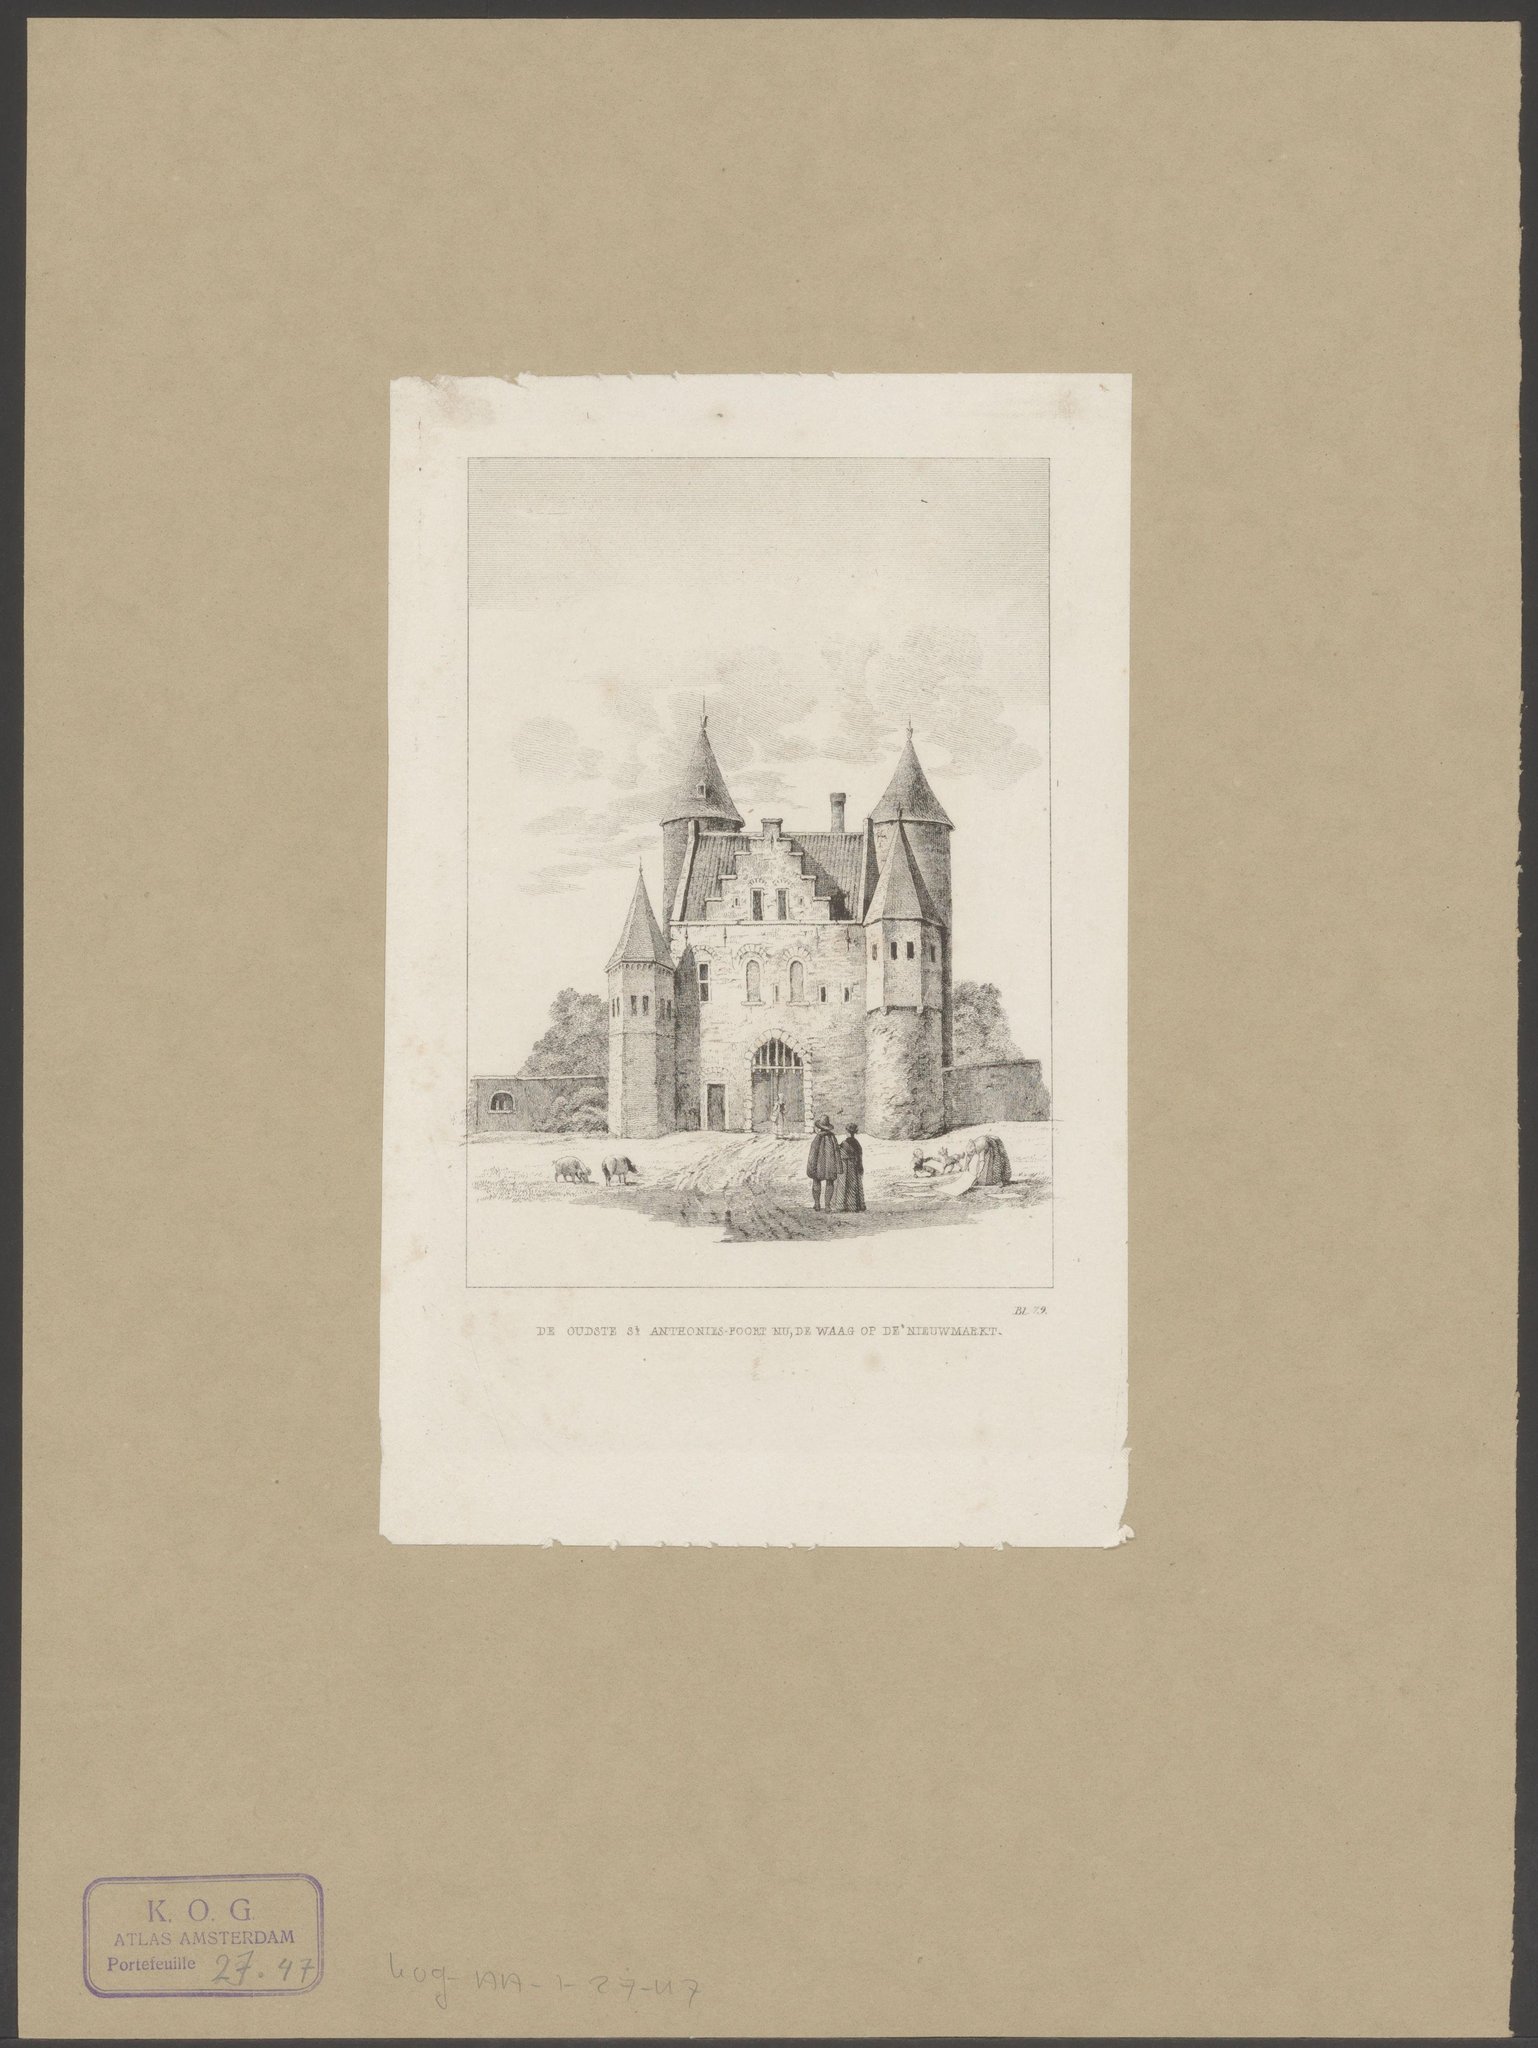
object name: print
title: Gezicht op de Eerste Sint-Antoniespoort te Amsterdam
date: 1844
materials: paper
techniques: lithograph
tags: bridge in city across river, canal, etc., city-gate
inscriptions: collector's mark: Lugt 1641b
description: Prent mogelijk uit: Vijver, Cornelius van der. Geschiedkundige beschrijving der stad Amsterdam: sedert hare wording tot op den tegenwoordigen tijd. 4 dln. Amsterdam: Gebroeders Diedrichs, 1844, dl. 1.